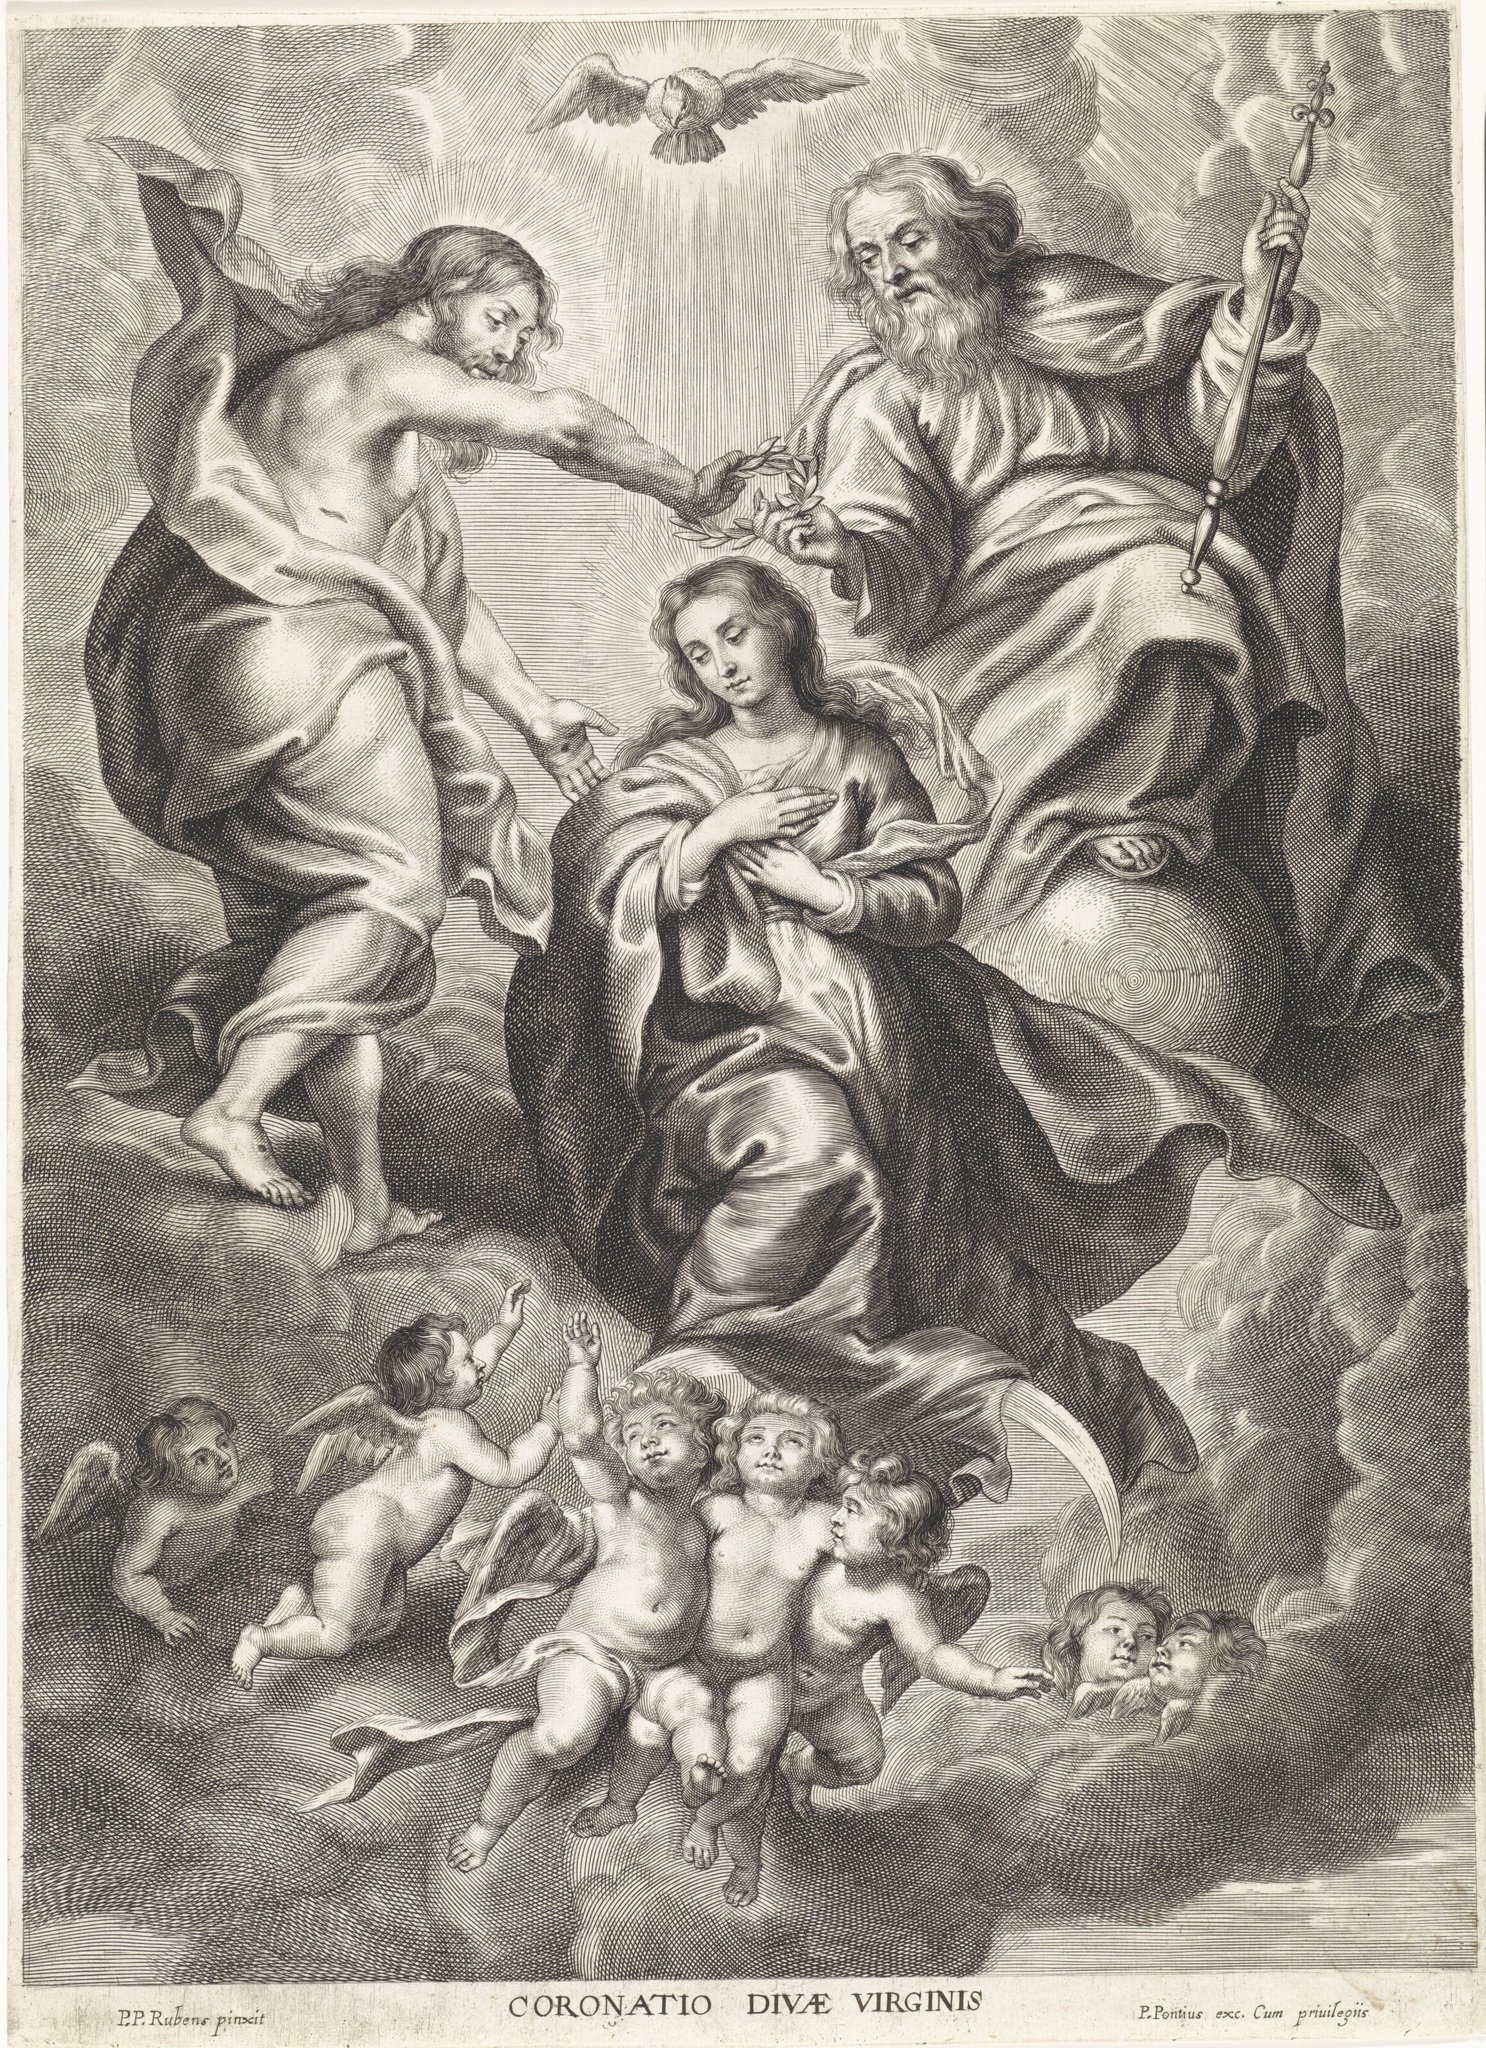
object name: print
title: Coronatio divæ virginis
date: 1616-1657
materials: paper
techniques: engraving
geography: antwerp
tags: coronation of mary by god the father and christ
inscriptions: collector's mark: Lugt 240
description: Maria wordt gelauwerd door de Drieëenheid, respectievelijk Christus, de duif en God de Vader. Ze worden vergezeld door engelen.